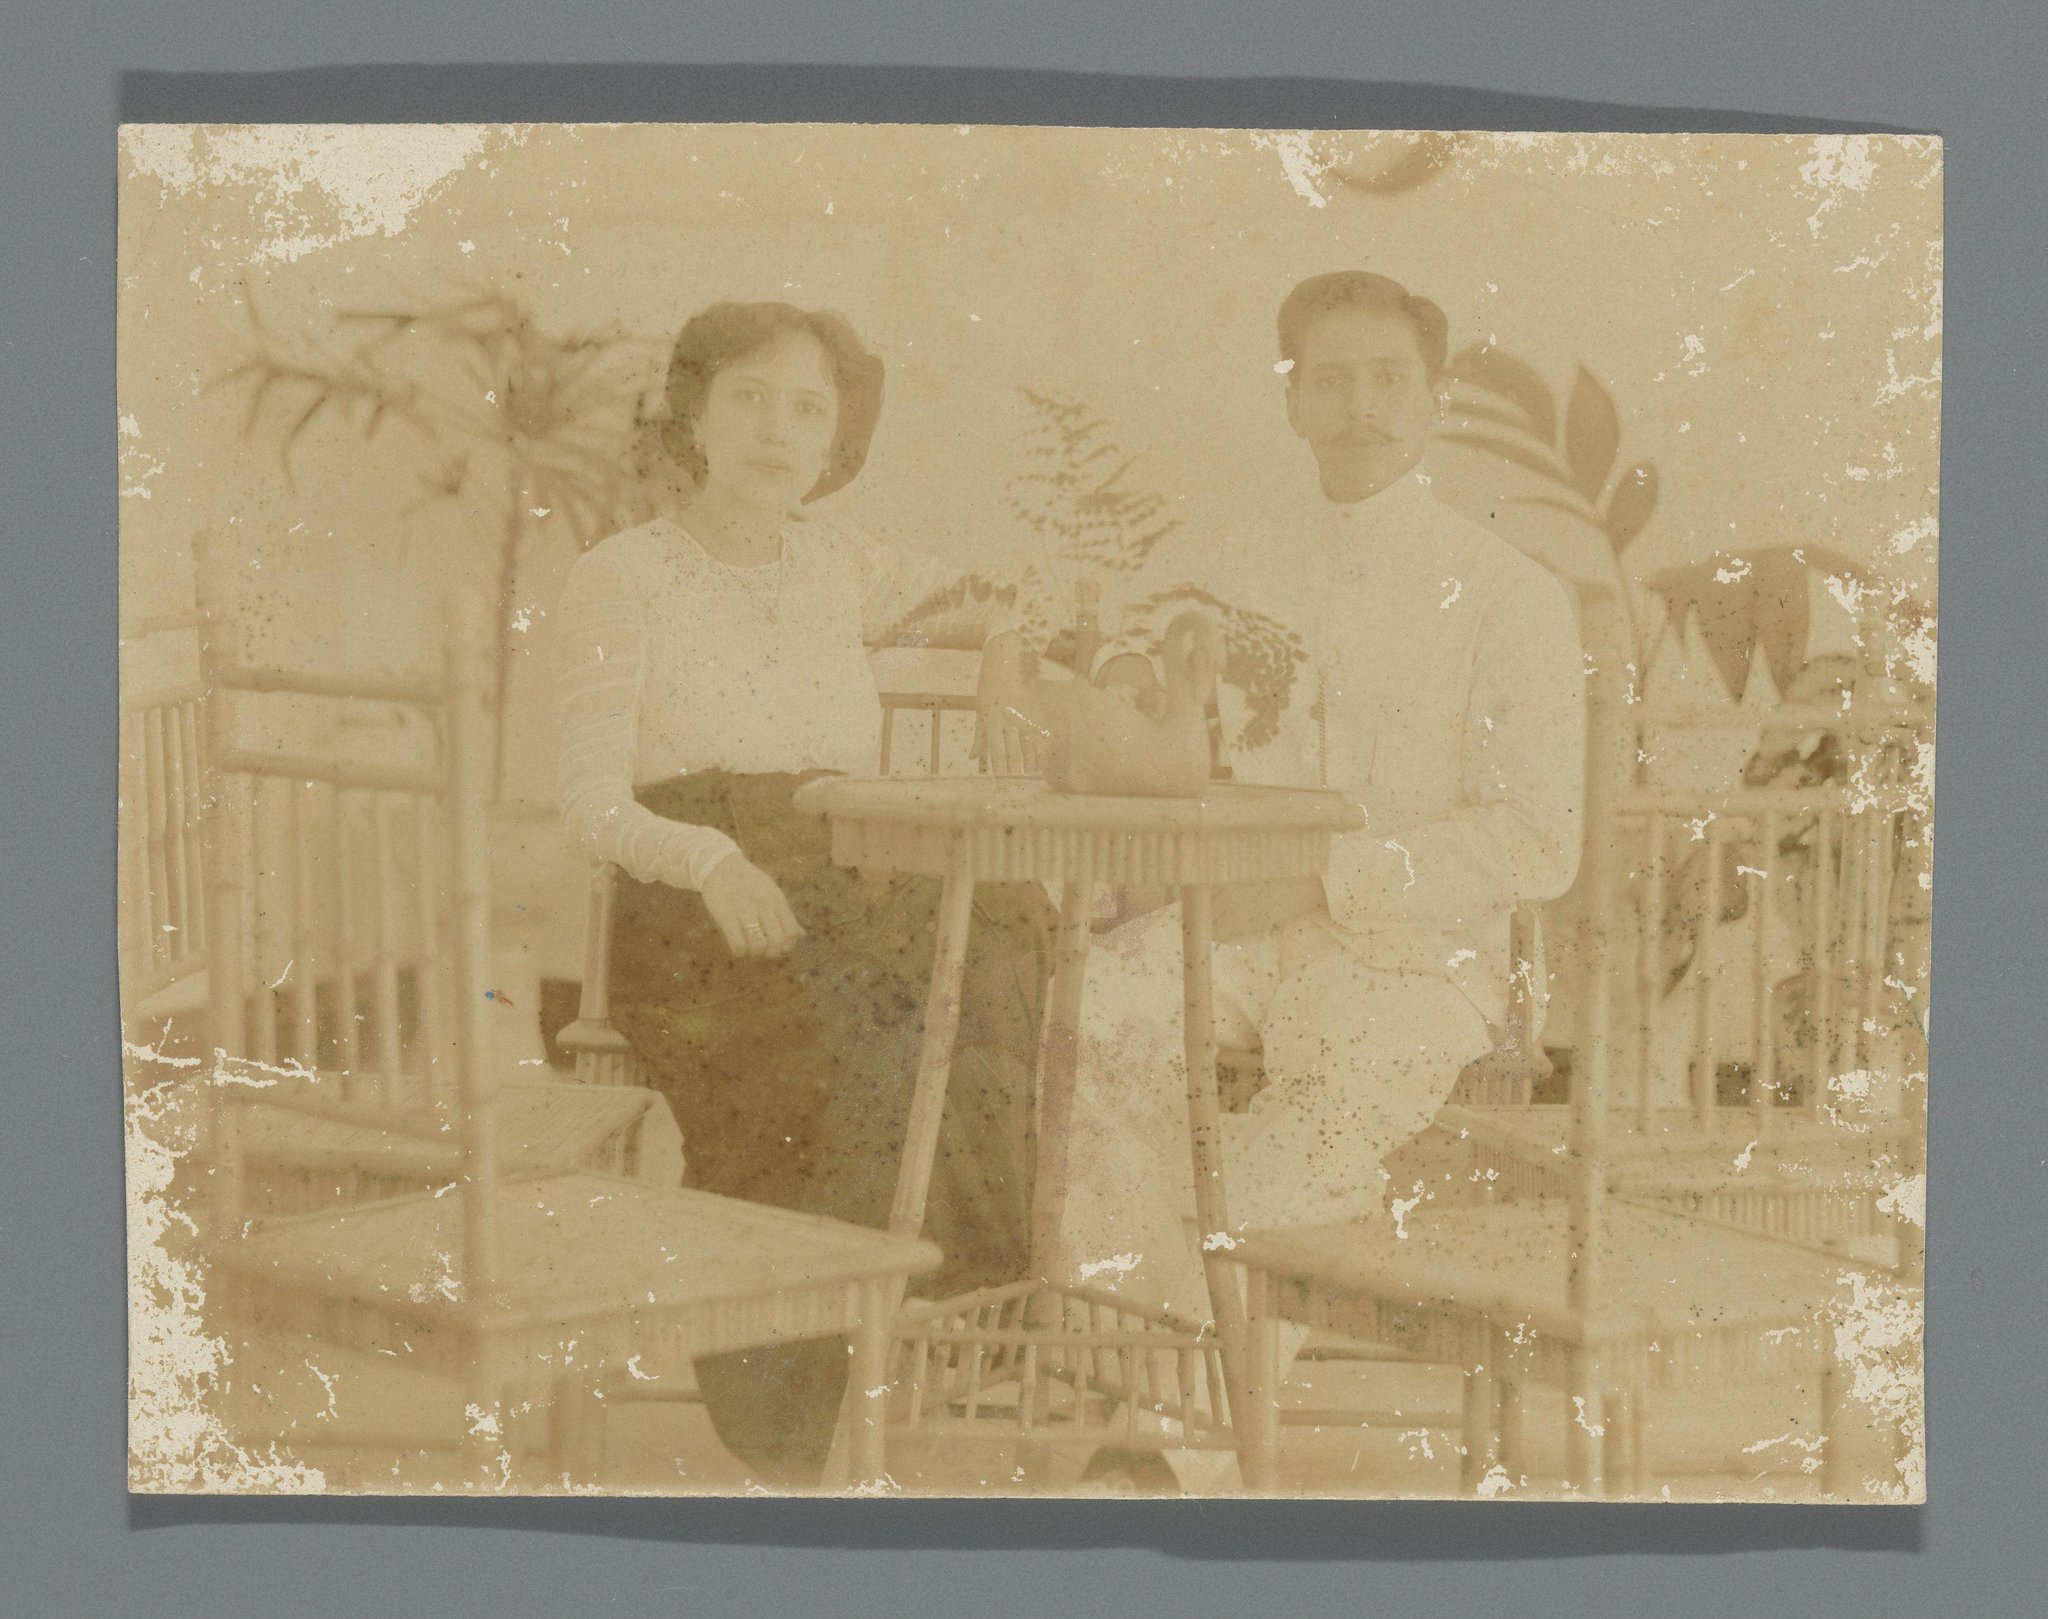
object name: photograph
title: Portret van Frédéric Dumas en Guusje Bruins ten tijde van hun huwelijk op veranda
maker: Anonymous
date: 1910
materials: photographic support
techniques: gelatin silver print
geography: dutch east indies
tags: surabaya, engineer, frédéric gabriël dumas, java, betrothal, dutch east indies, the